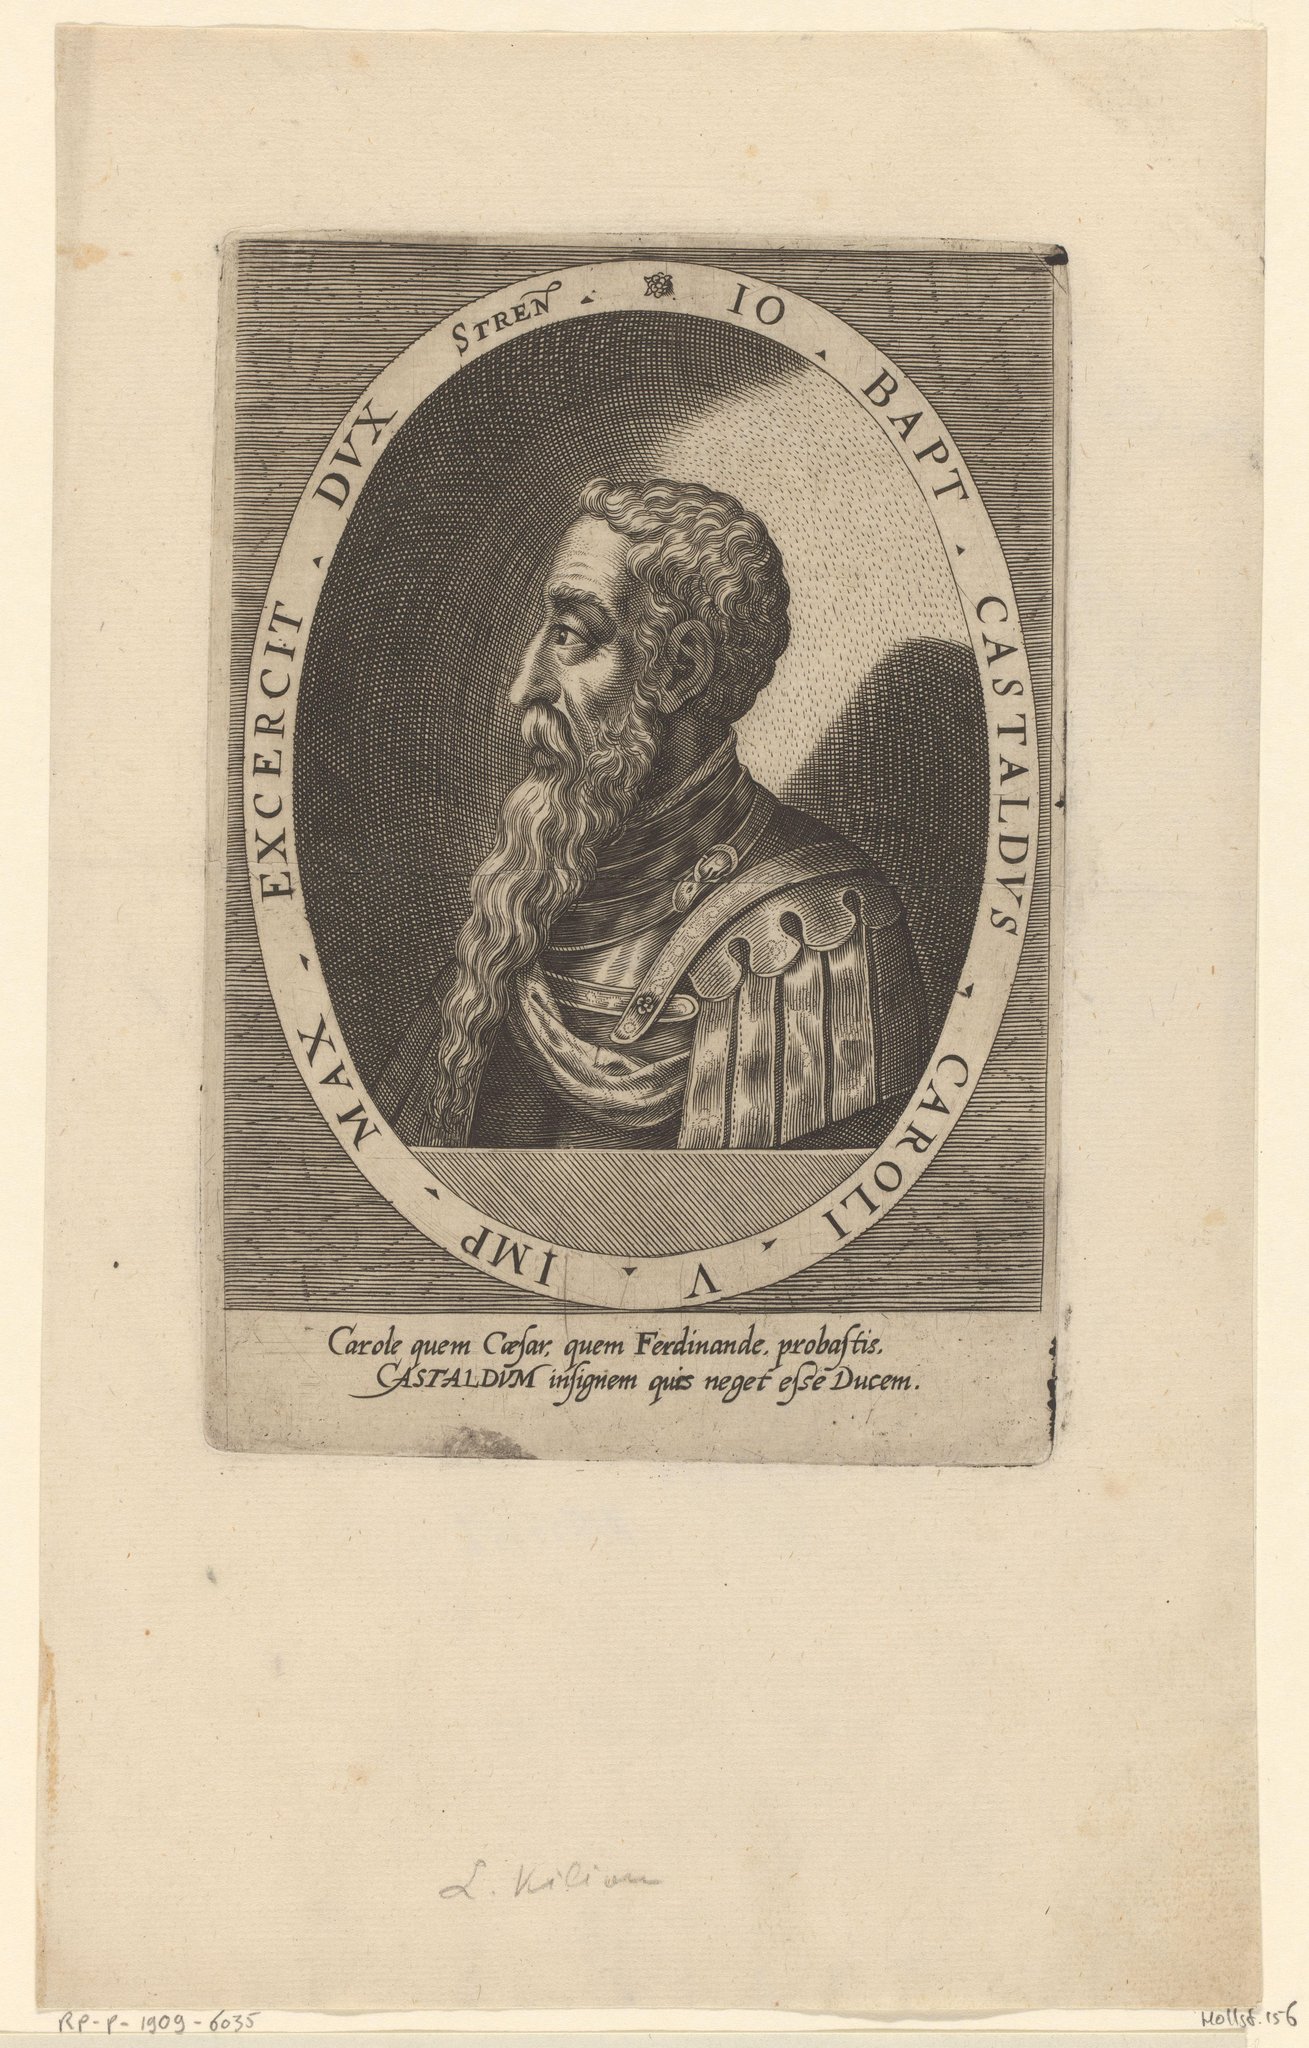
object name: print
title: Portret van Giovan Battista Castaldo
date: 1589-1637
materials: paper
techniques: engraving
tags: engineer, engineering (+ portrait of scholar, scientist), historical persons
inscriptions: collector's mark: Lugt 2228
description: Tekst in het Latijn in de omlijsting en in de ondermarge.